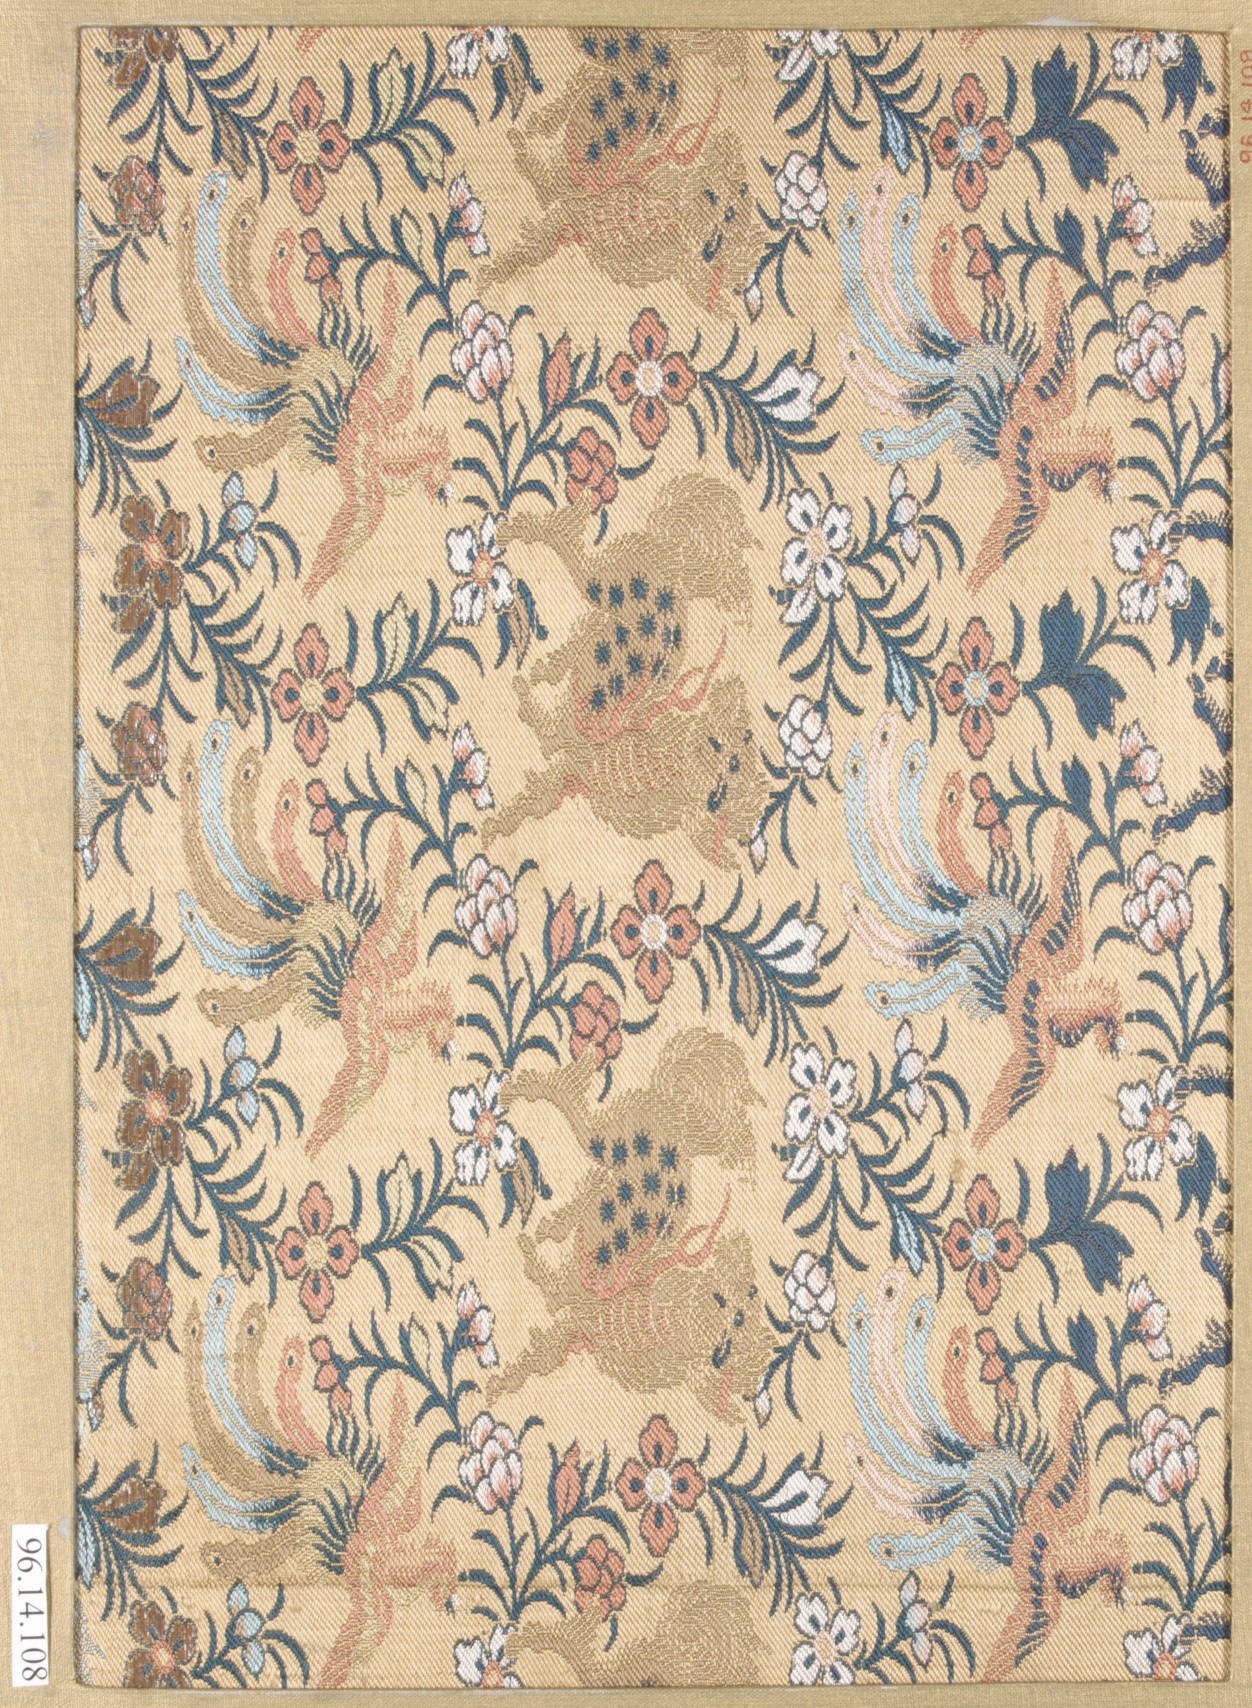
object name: piece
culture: japanese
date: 1701-1900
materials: silk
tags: flowers